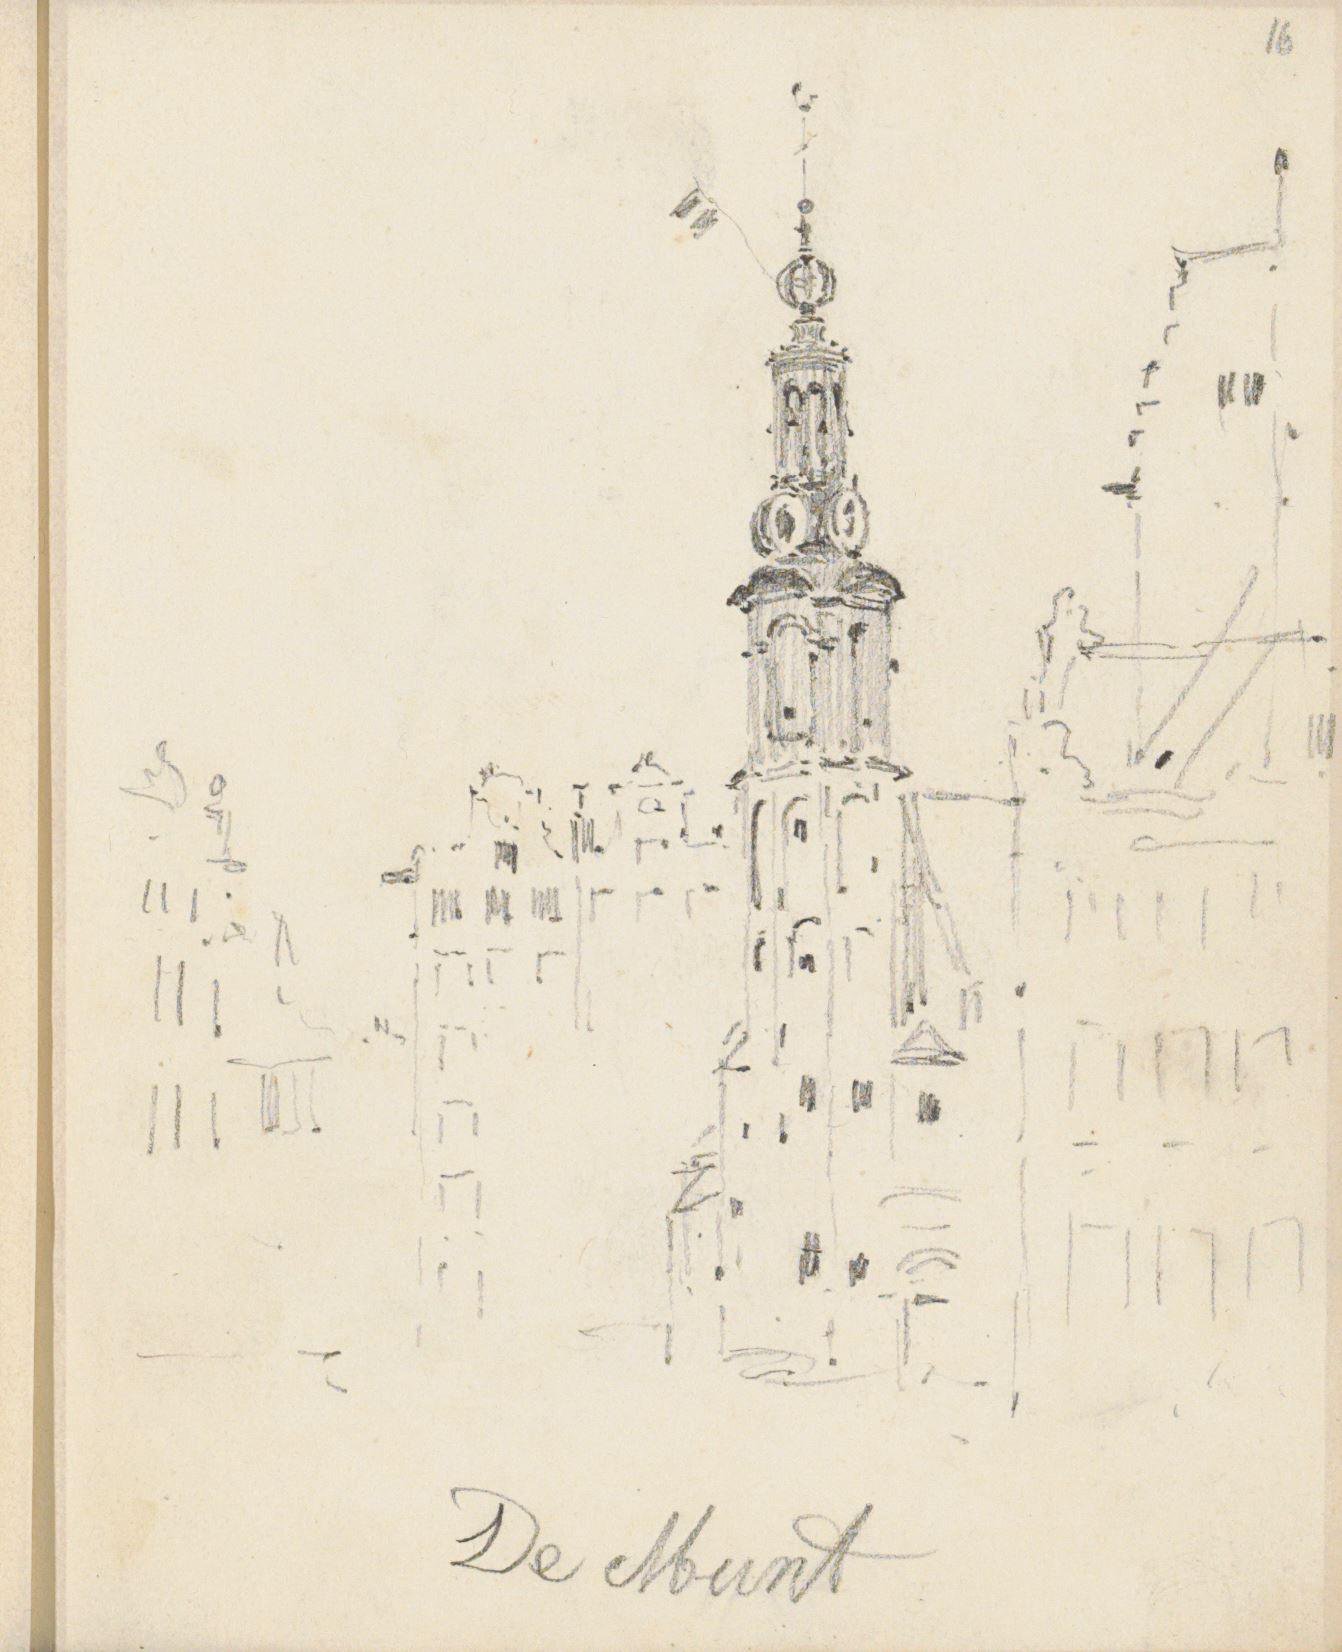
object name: sketchbook leaf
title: Munttoren te Amsterdam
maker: alfred william rich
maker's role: draughtsman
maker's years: 1856-1921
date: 1892-1893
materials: paper, pencil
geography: amsterdam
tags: tower (of house or building)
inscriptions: annotation: ‘De Munt’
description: Blad 16 recto uit een schetsboek met 86 bladen.